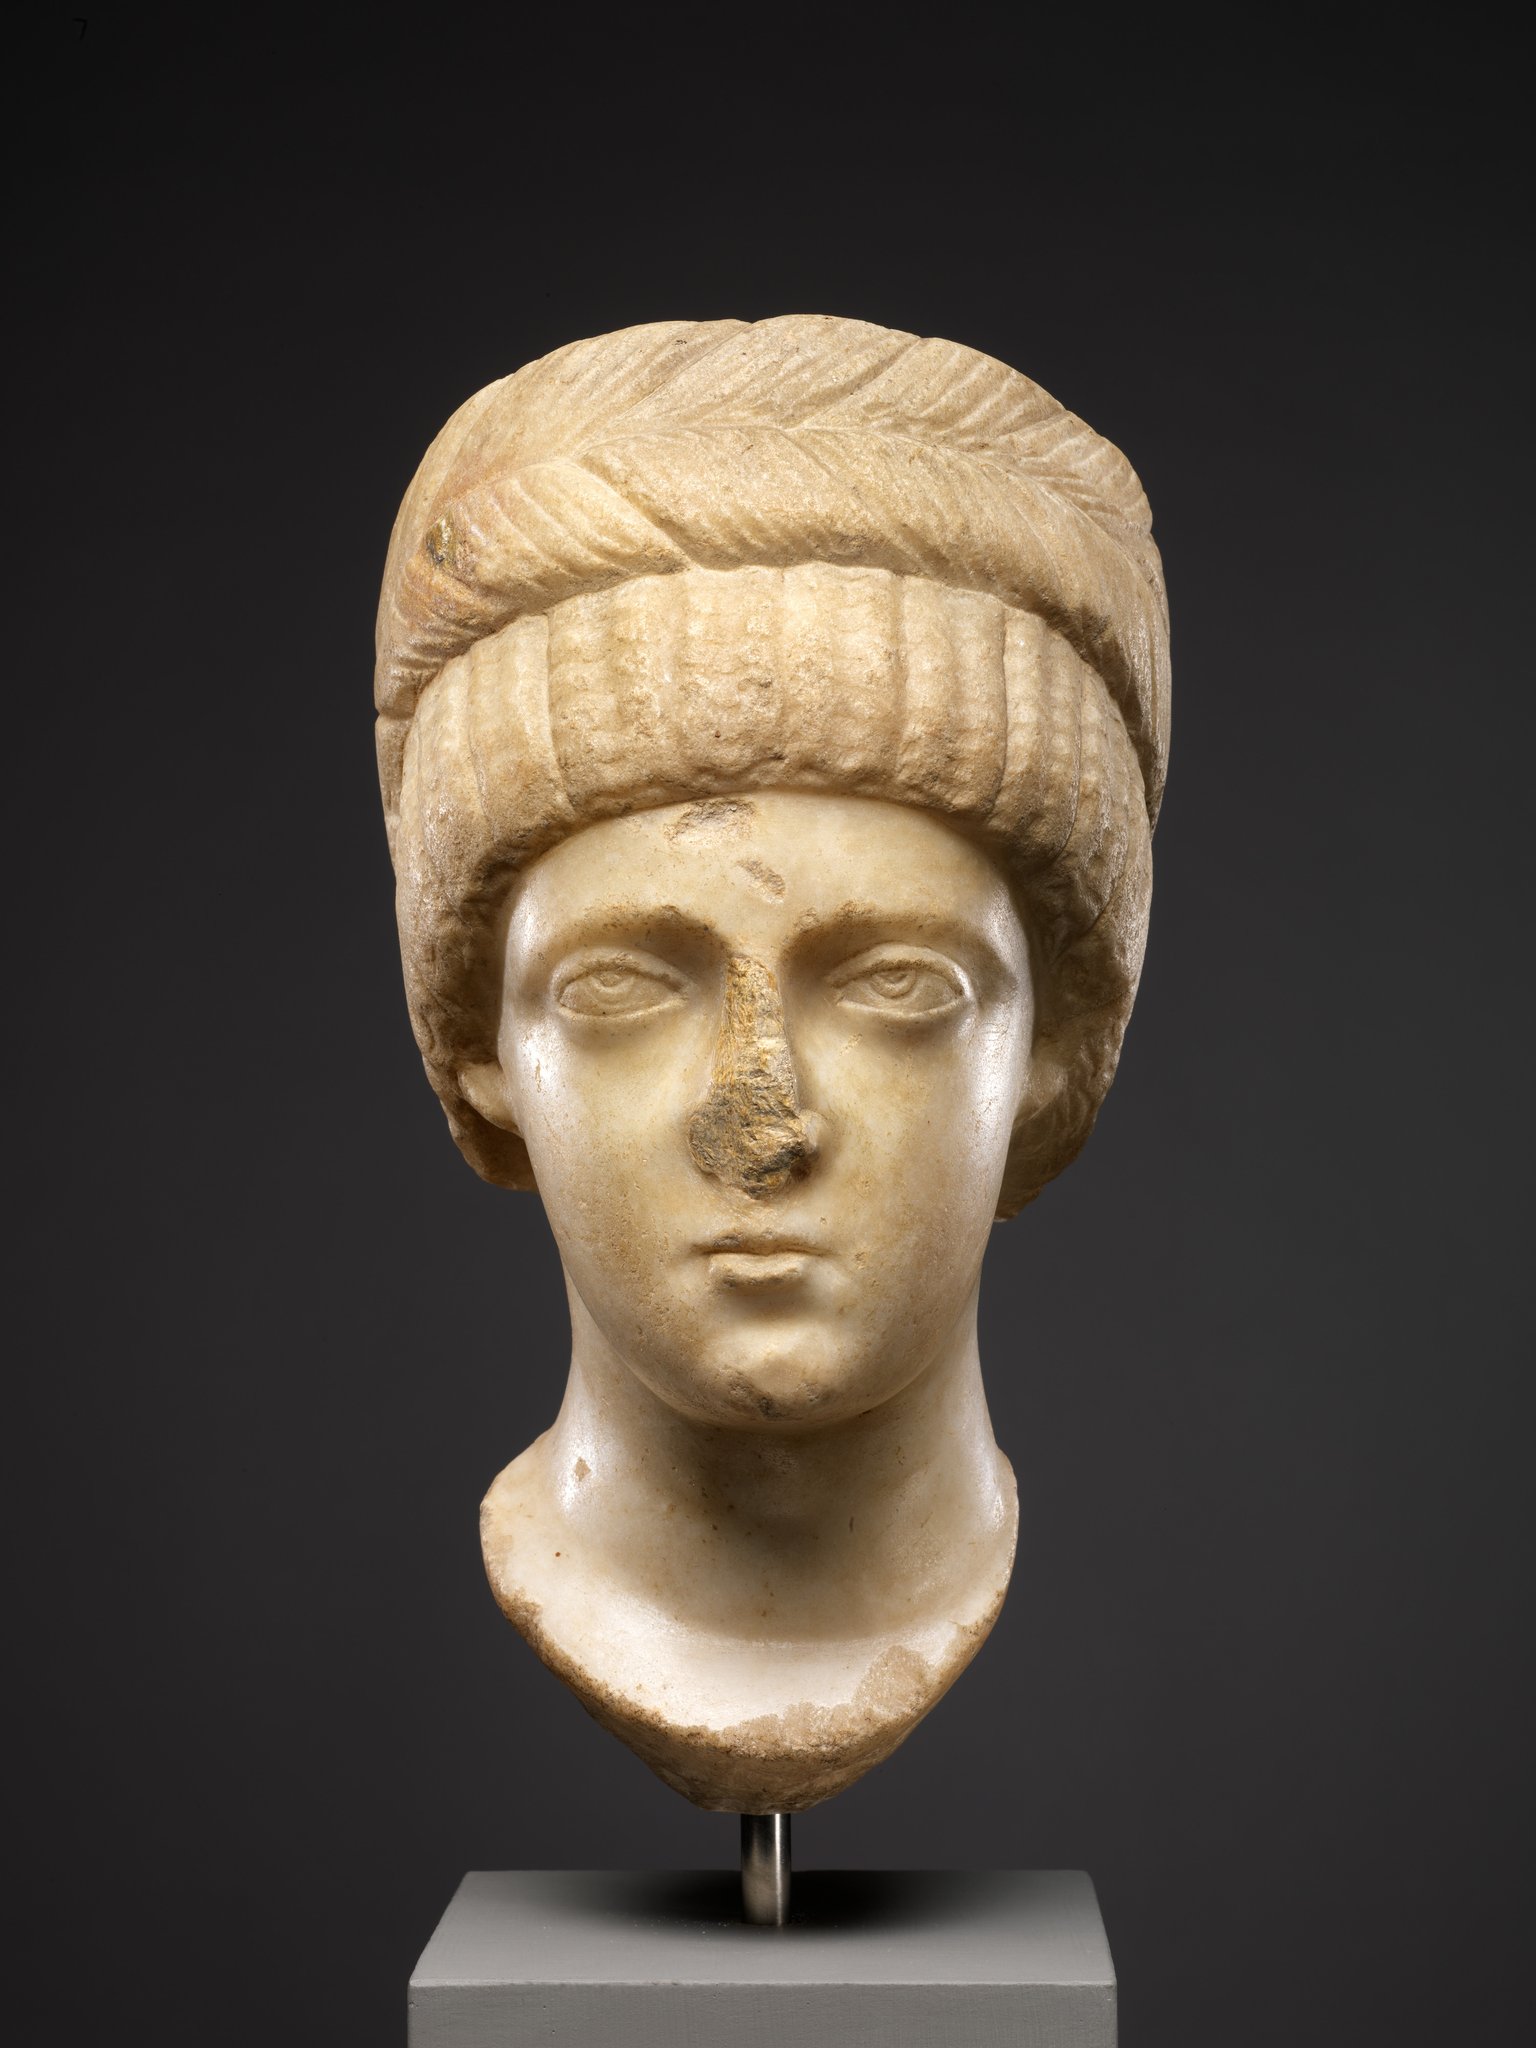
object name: statue head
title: Head, Possibly of Empress Flaccilla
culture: byzantine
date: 380-390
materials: marble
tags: women